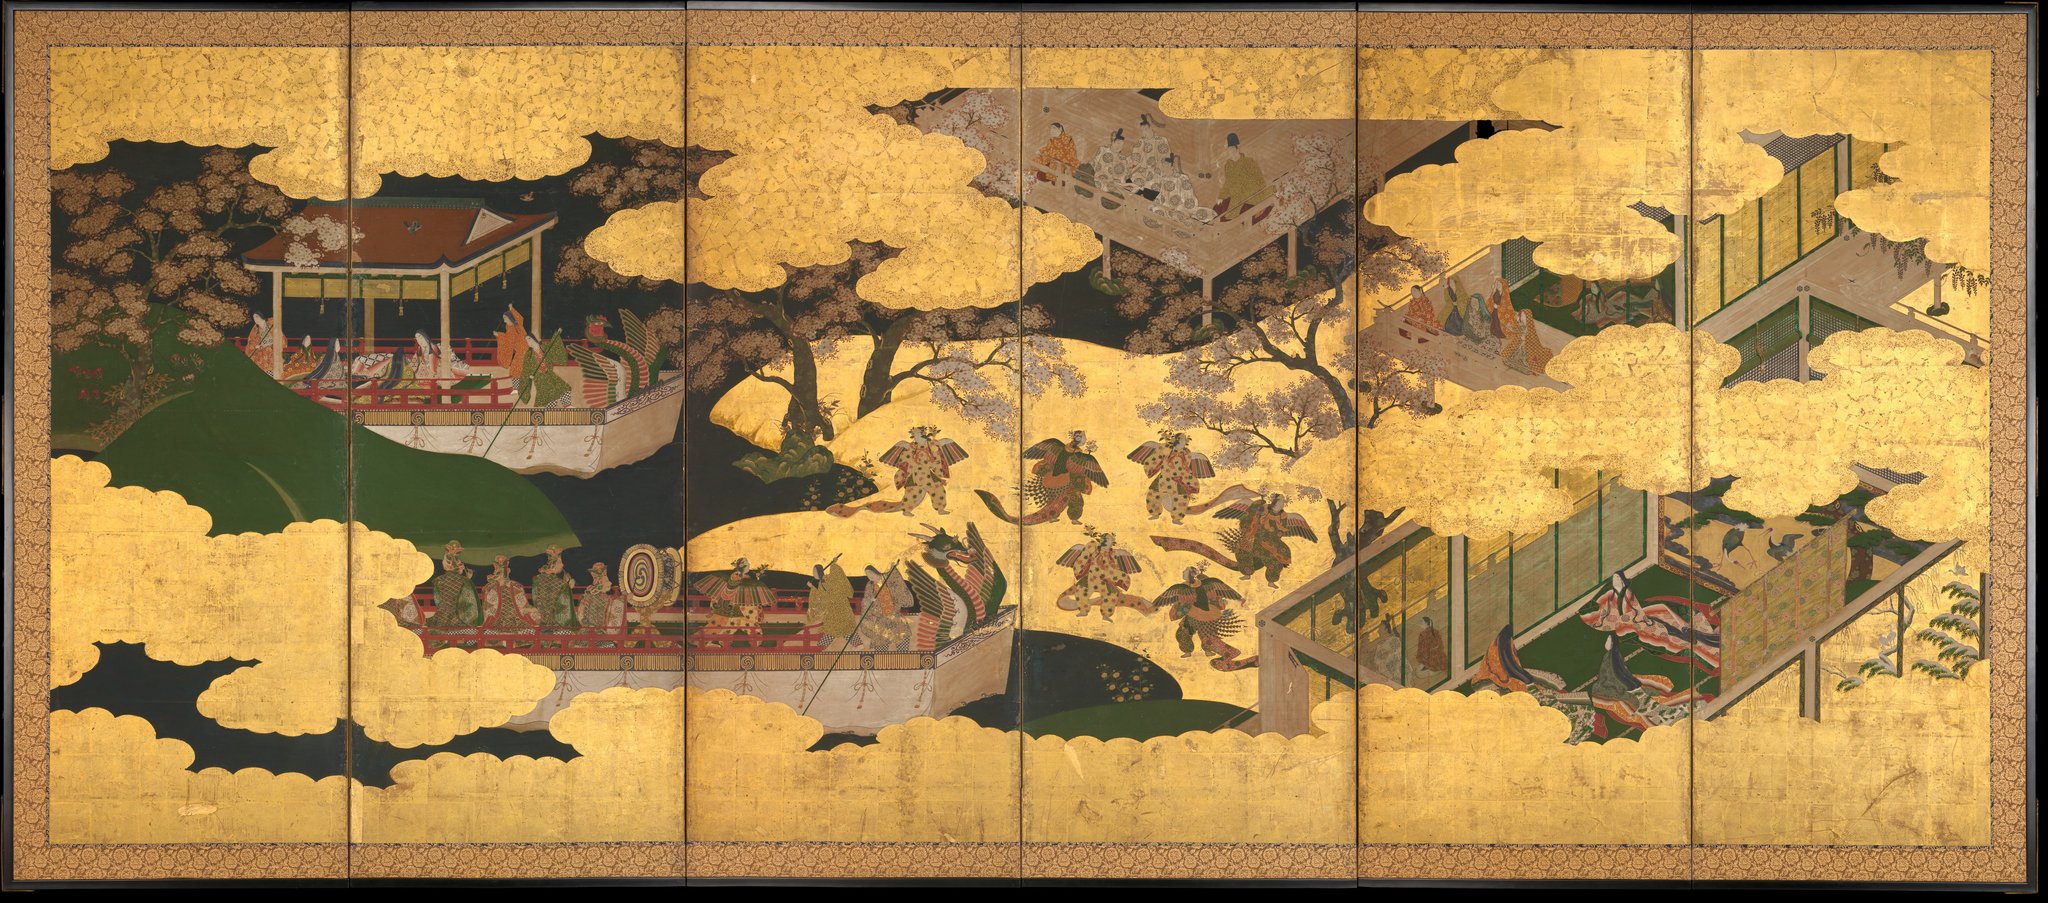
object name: screen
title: “Butterflies”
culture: japanese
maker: tosa mitsuyoshi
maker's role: artist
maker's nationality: japanese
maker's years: 1539-1613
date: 1567-1633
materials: gold, gold leaf, ink, panel, paper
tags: men,women,trees,boats